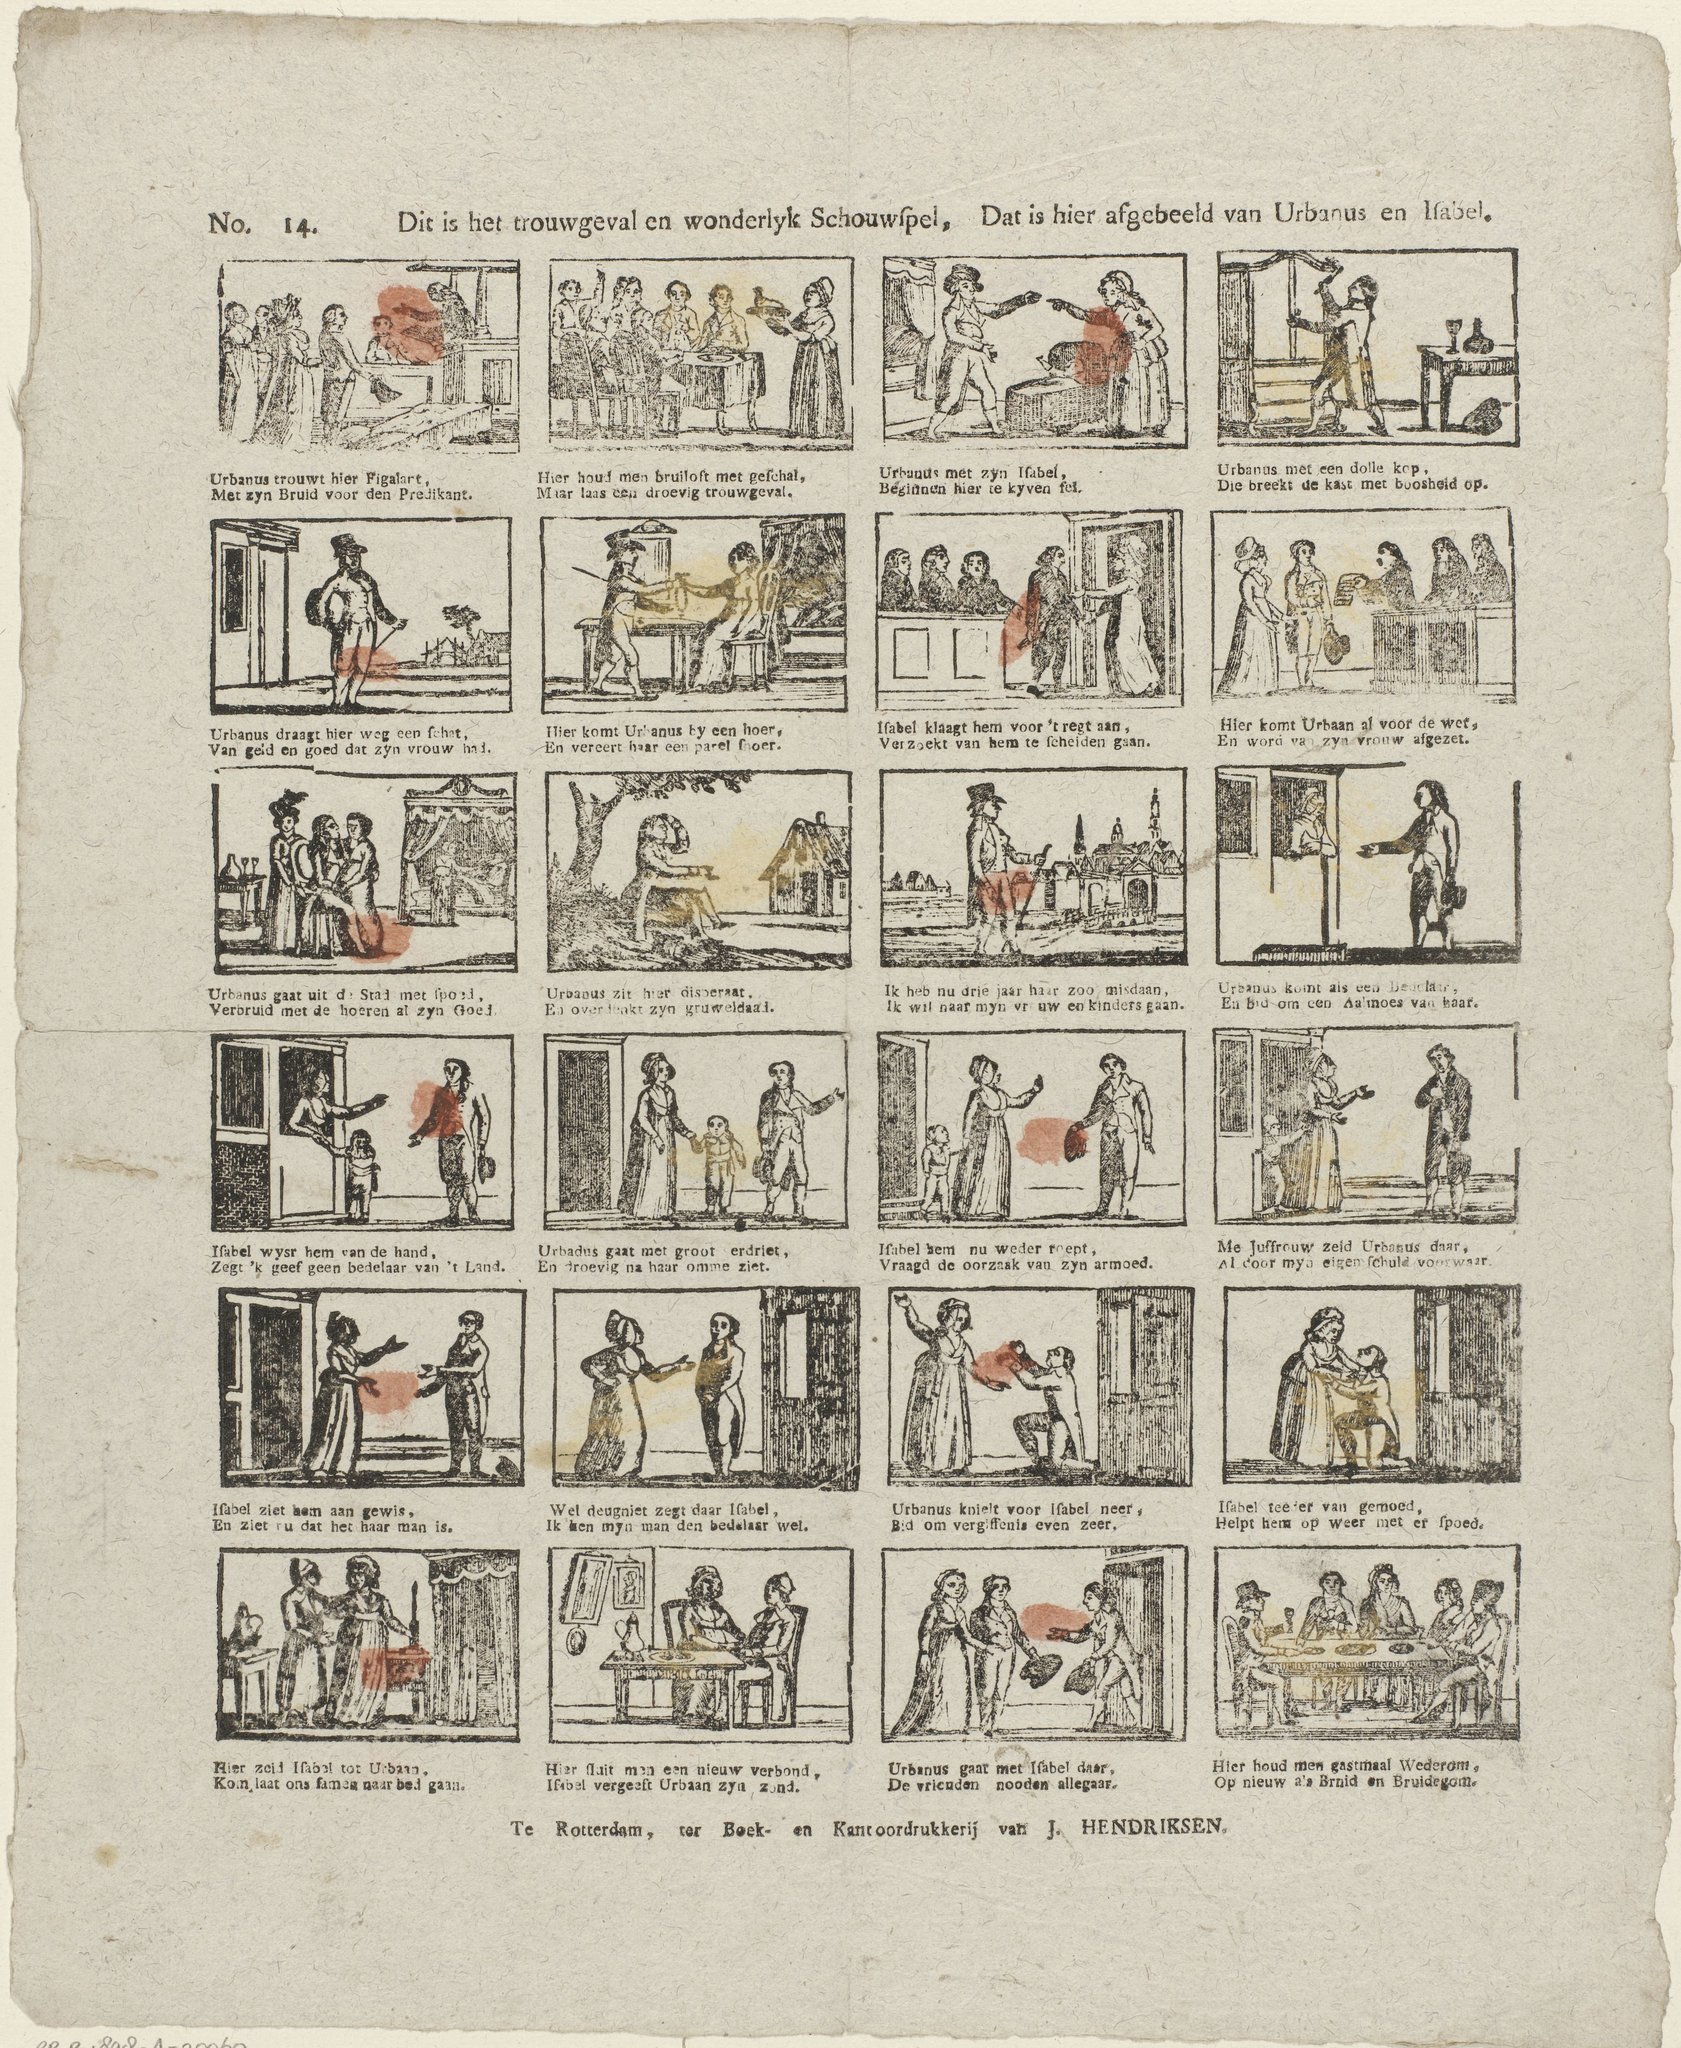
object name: print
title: Dit is het trouwgeval en wondellyk schouwspel / Dat is hier afgebeeld van Urbanus en Isabel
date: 1781-1828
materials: paper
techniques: colour, letterpress printing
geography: rotterdam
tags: divorce, beggar, man and wife quarrelling, 'marriage à la mode'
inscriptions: collector's mark: Lugt 2228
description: Blad met 24 voorstellingen uit het leven van Urbanus en Isabel. Ze trouwen, maken ruzie, gaan scheiden, en Urbanus wordt een bedelaar. Onder elke voorstelling een tweeregelig vers. Genummerd linksboven: No, 14.